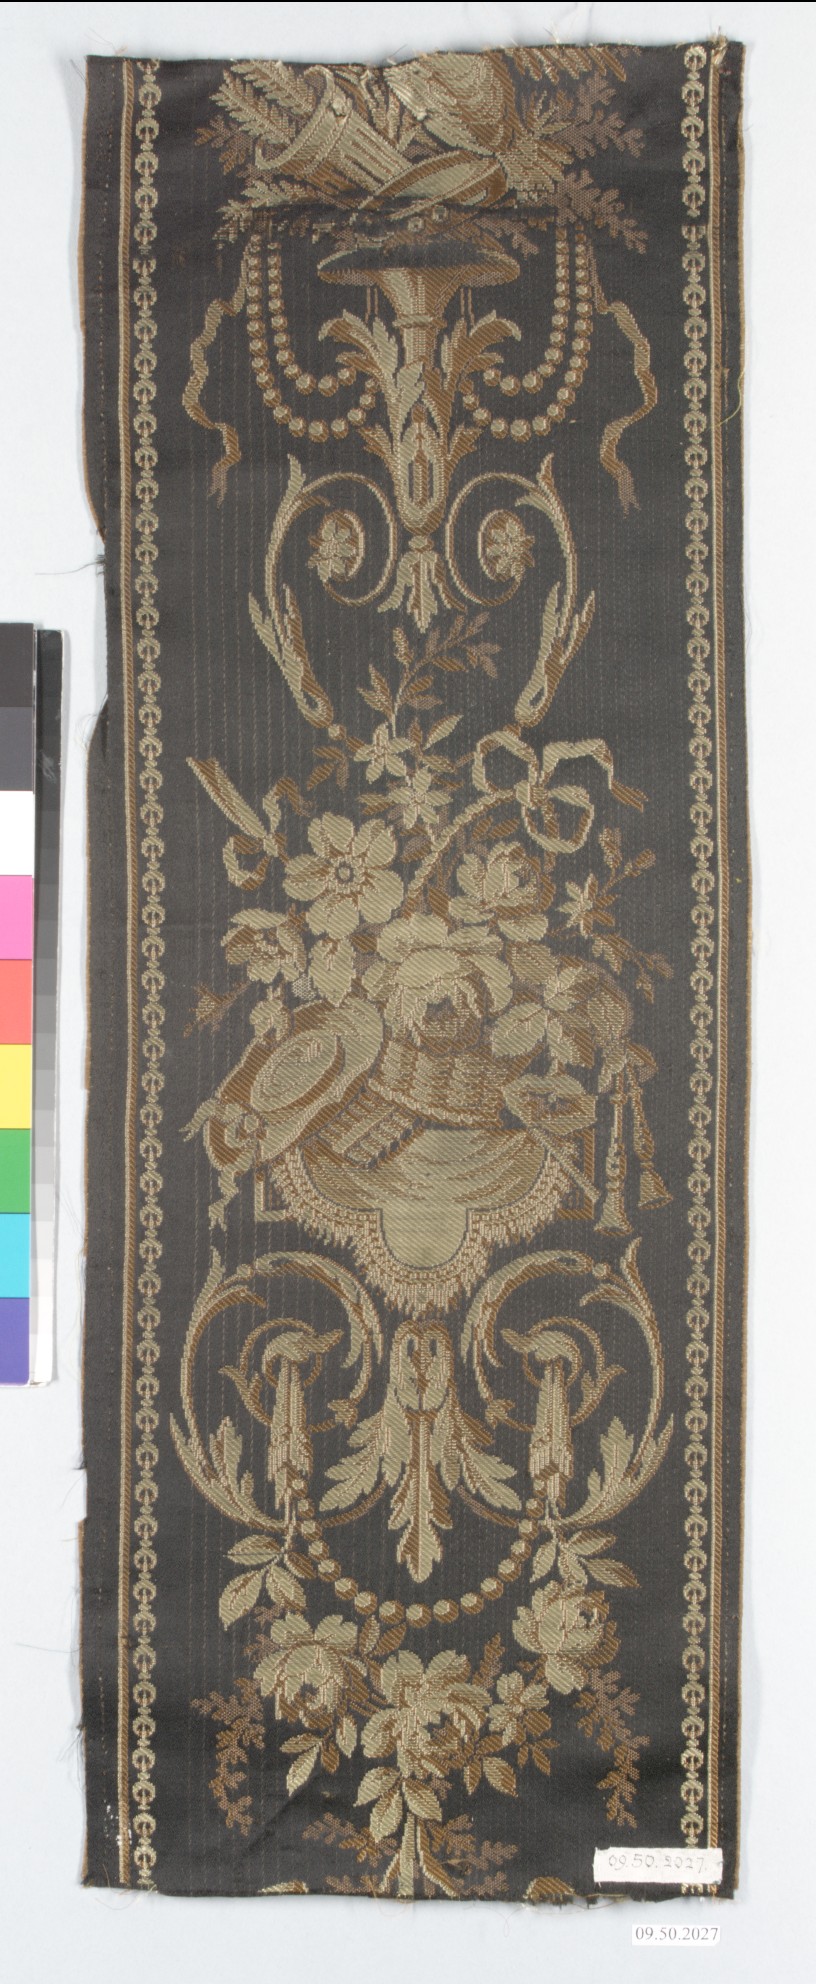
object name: ribbon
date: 1801-1900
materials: silk